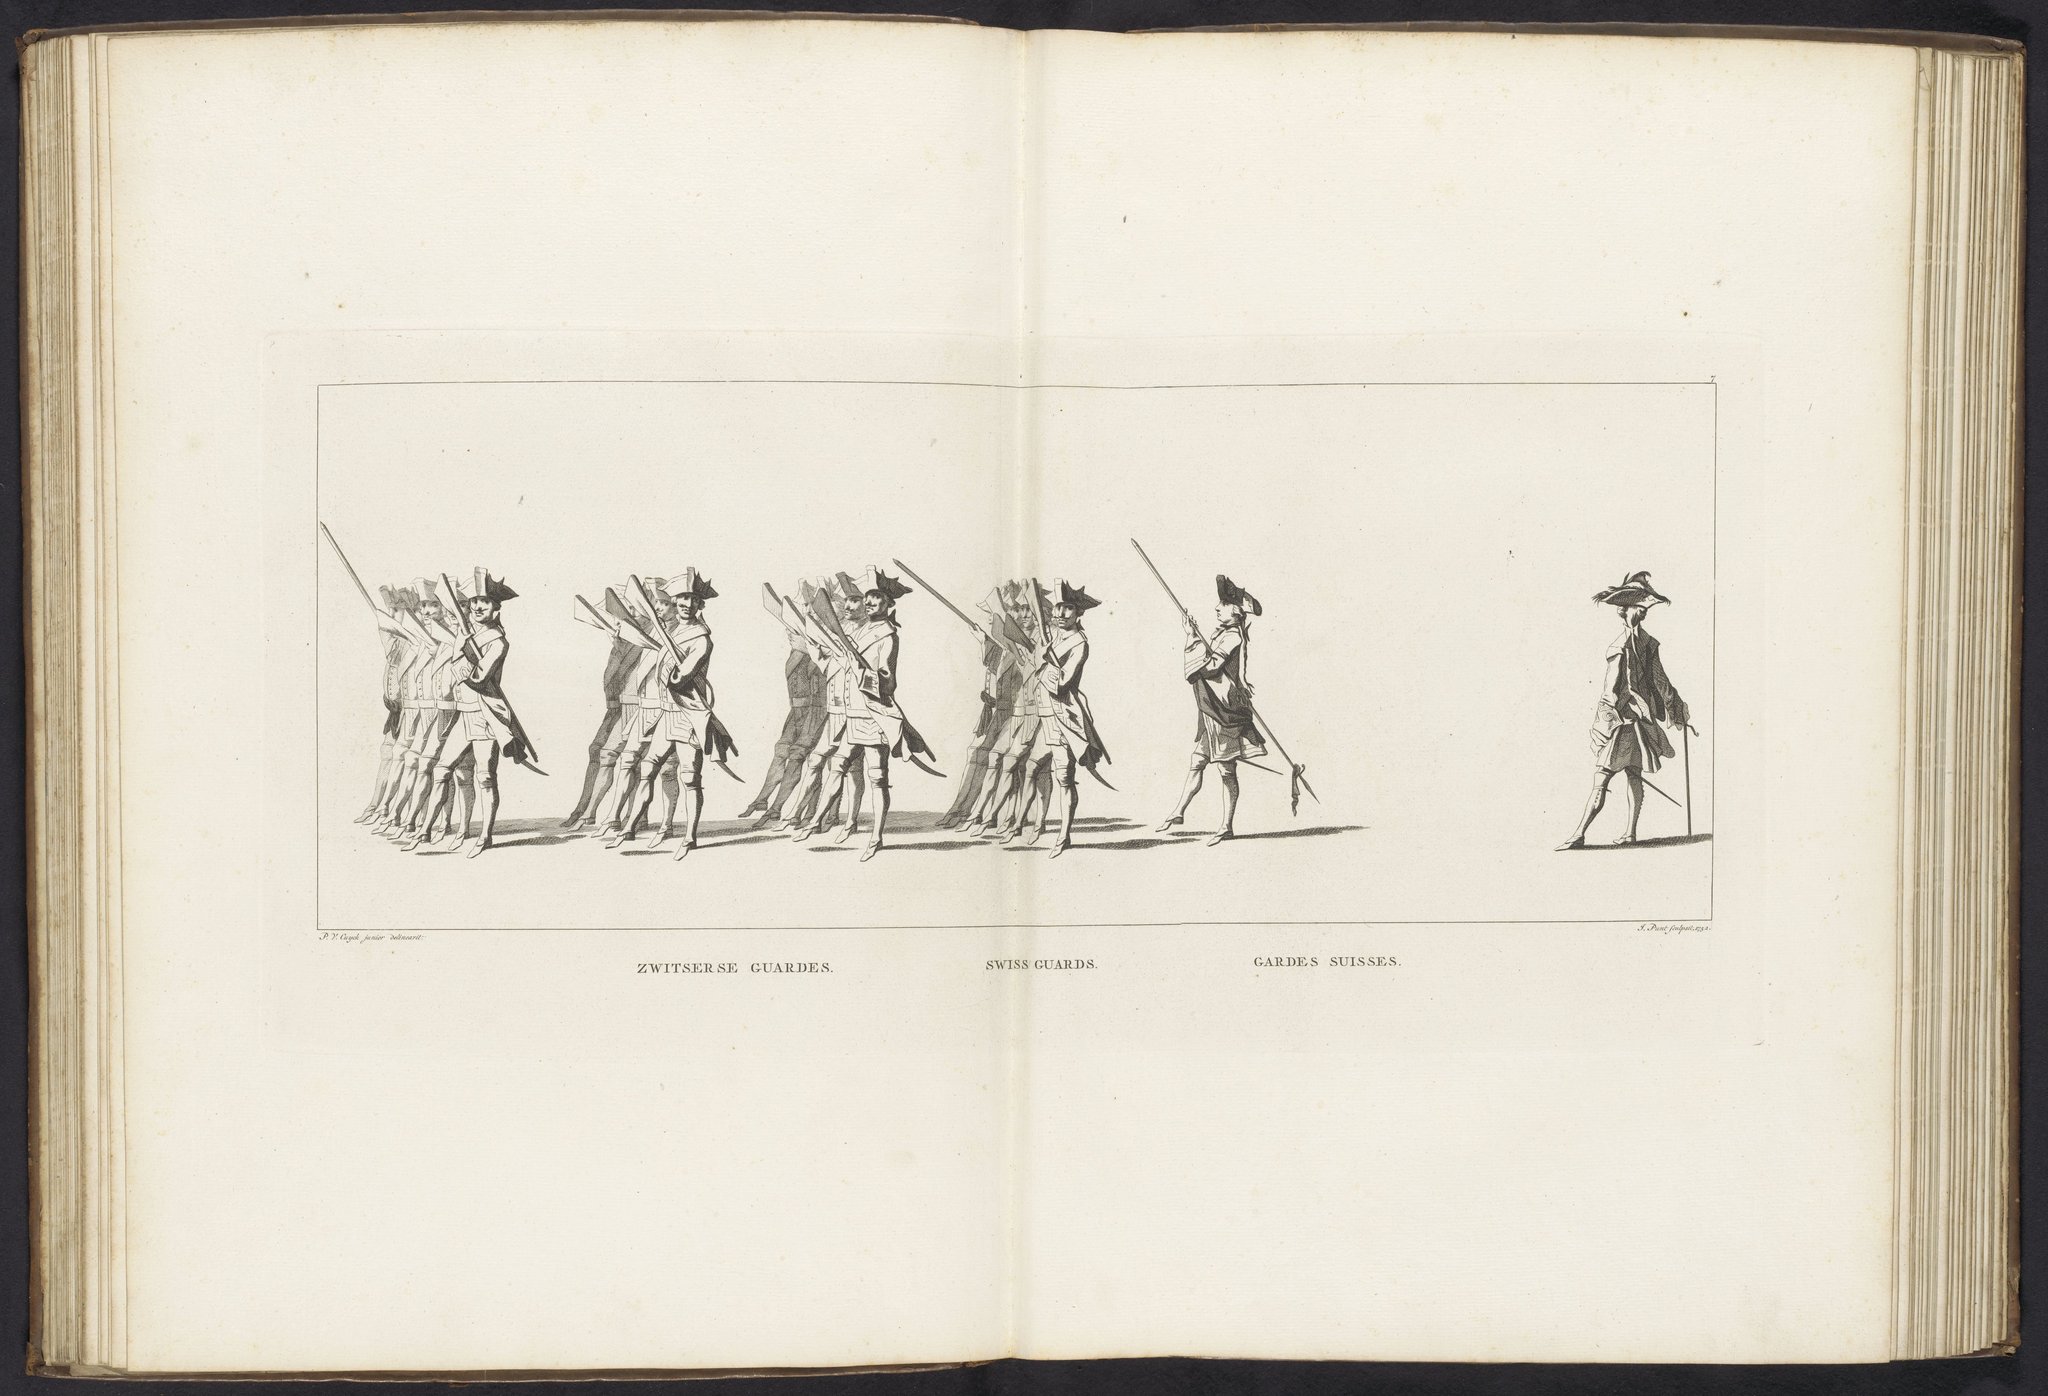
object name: print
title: Zwitserse Guardes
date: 1752-1755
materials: paper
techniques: engraving, etching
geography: northern netherlands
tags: the hague, willem iv (prins van oranje-nassau), military parade, pageant (+ infantry), cortege, funeral procession, delft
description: De Zwitserse Garde. In de marge het onderschrift in Nederlands, Frans en Engels. Onderdeel van een serie van 41 platen van de begrafenisstoet van stadhouder Willem IV te Delft op 4 februari 1752. Genummerd rechtsboven: 7. In de gebonden uitgave van 1755.